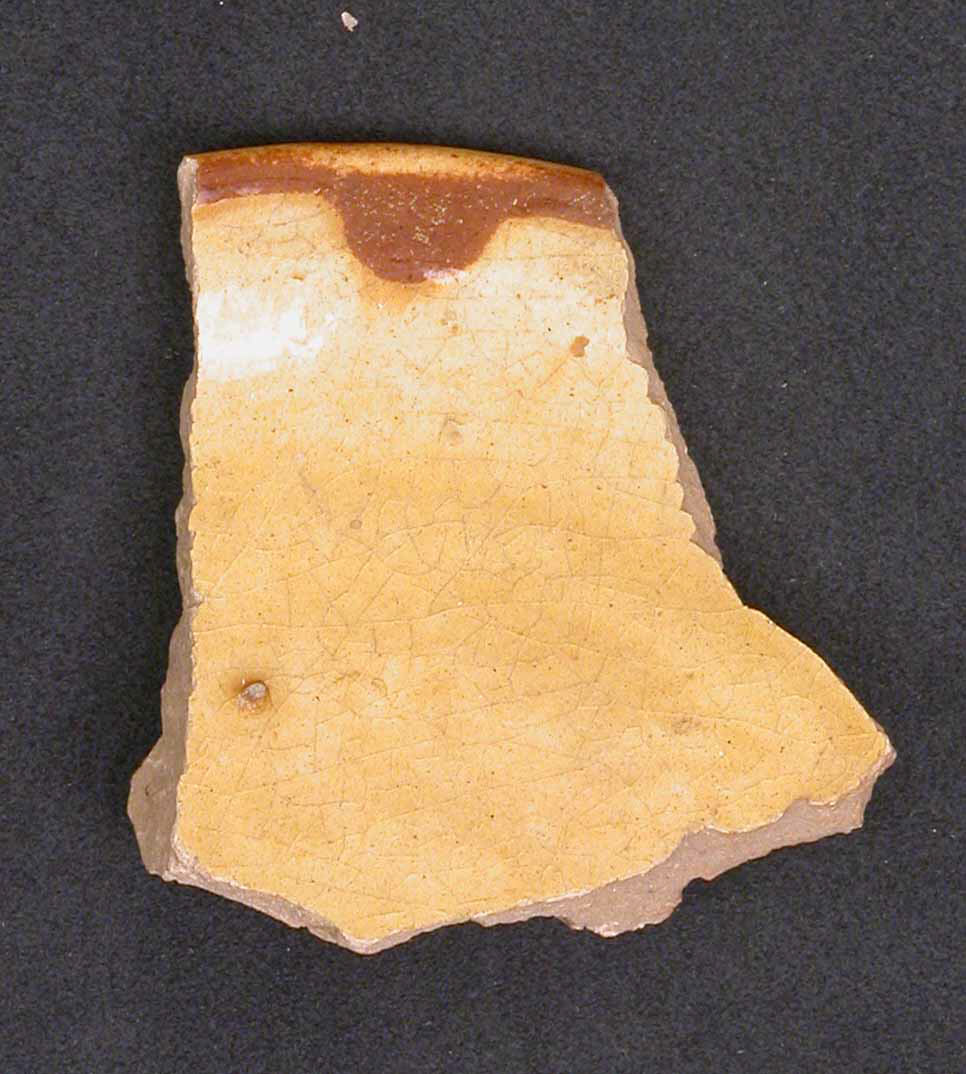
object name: fragment of a dish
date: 1501-1700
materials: earthenware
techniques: glazing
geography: iran